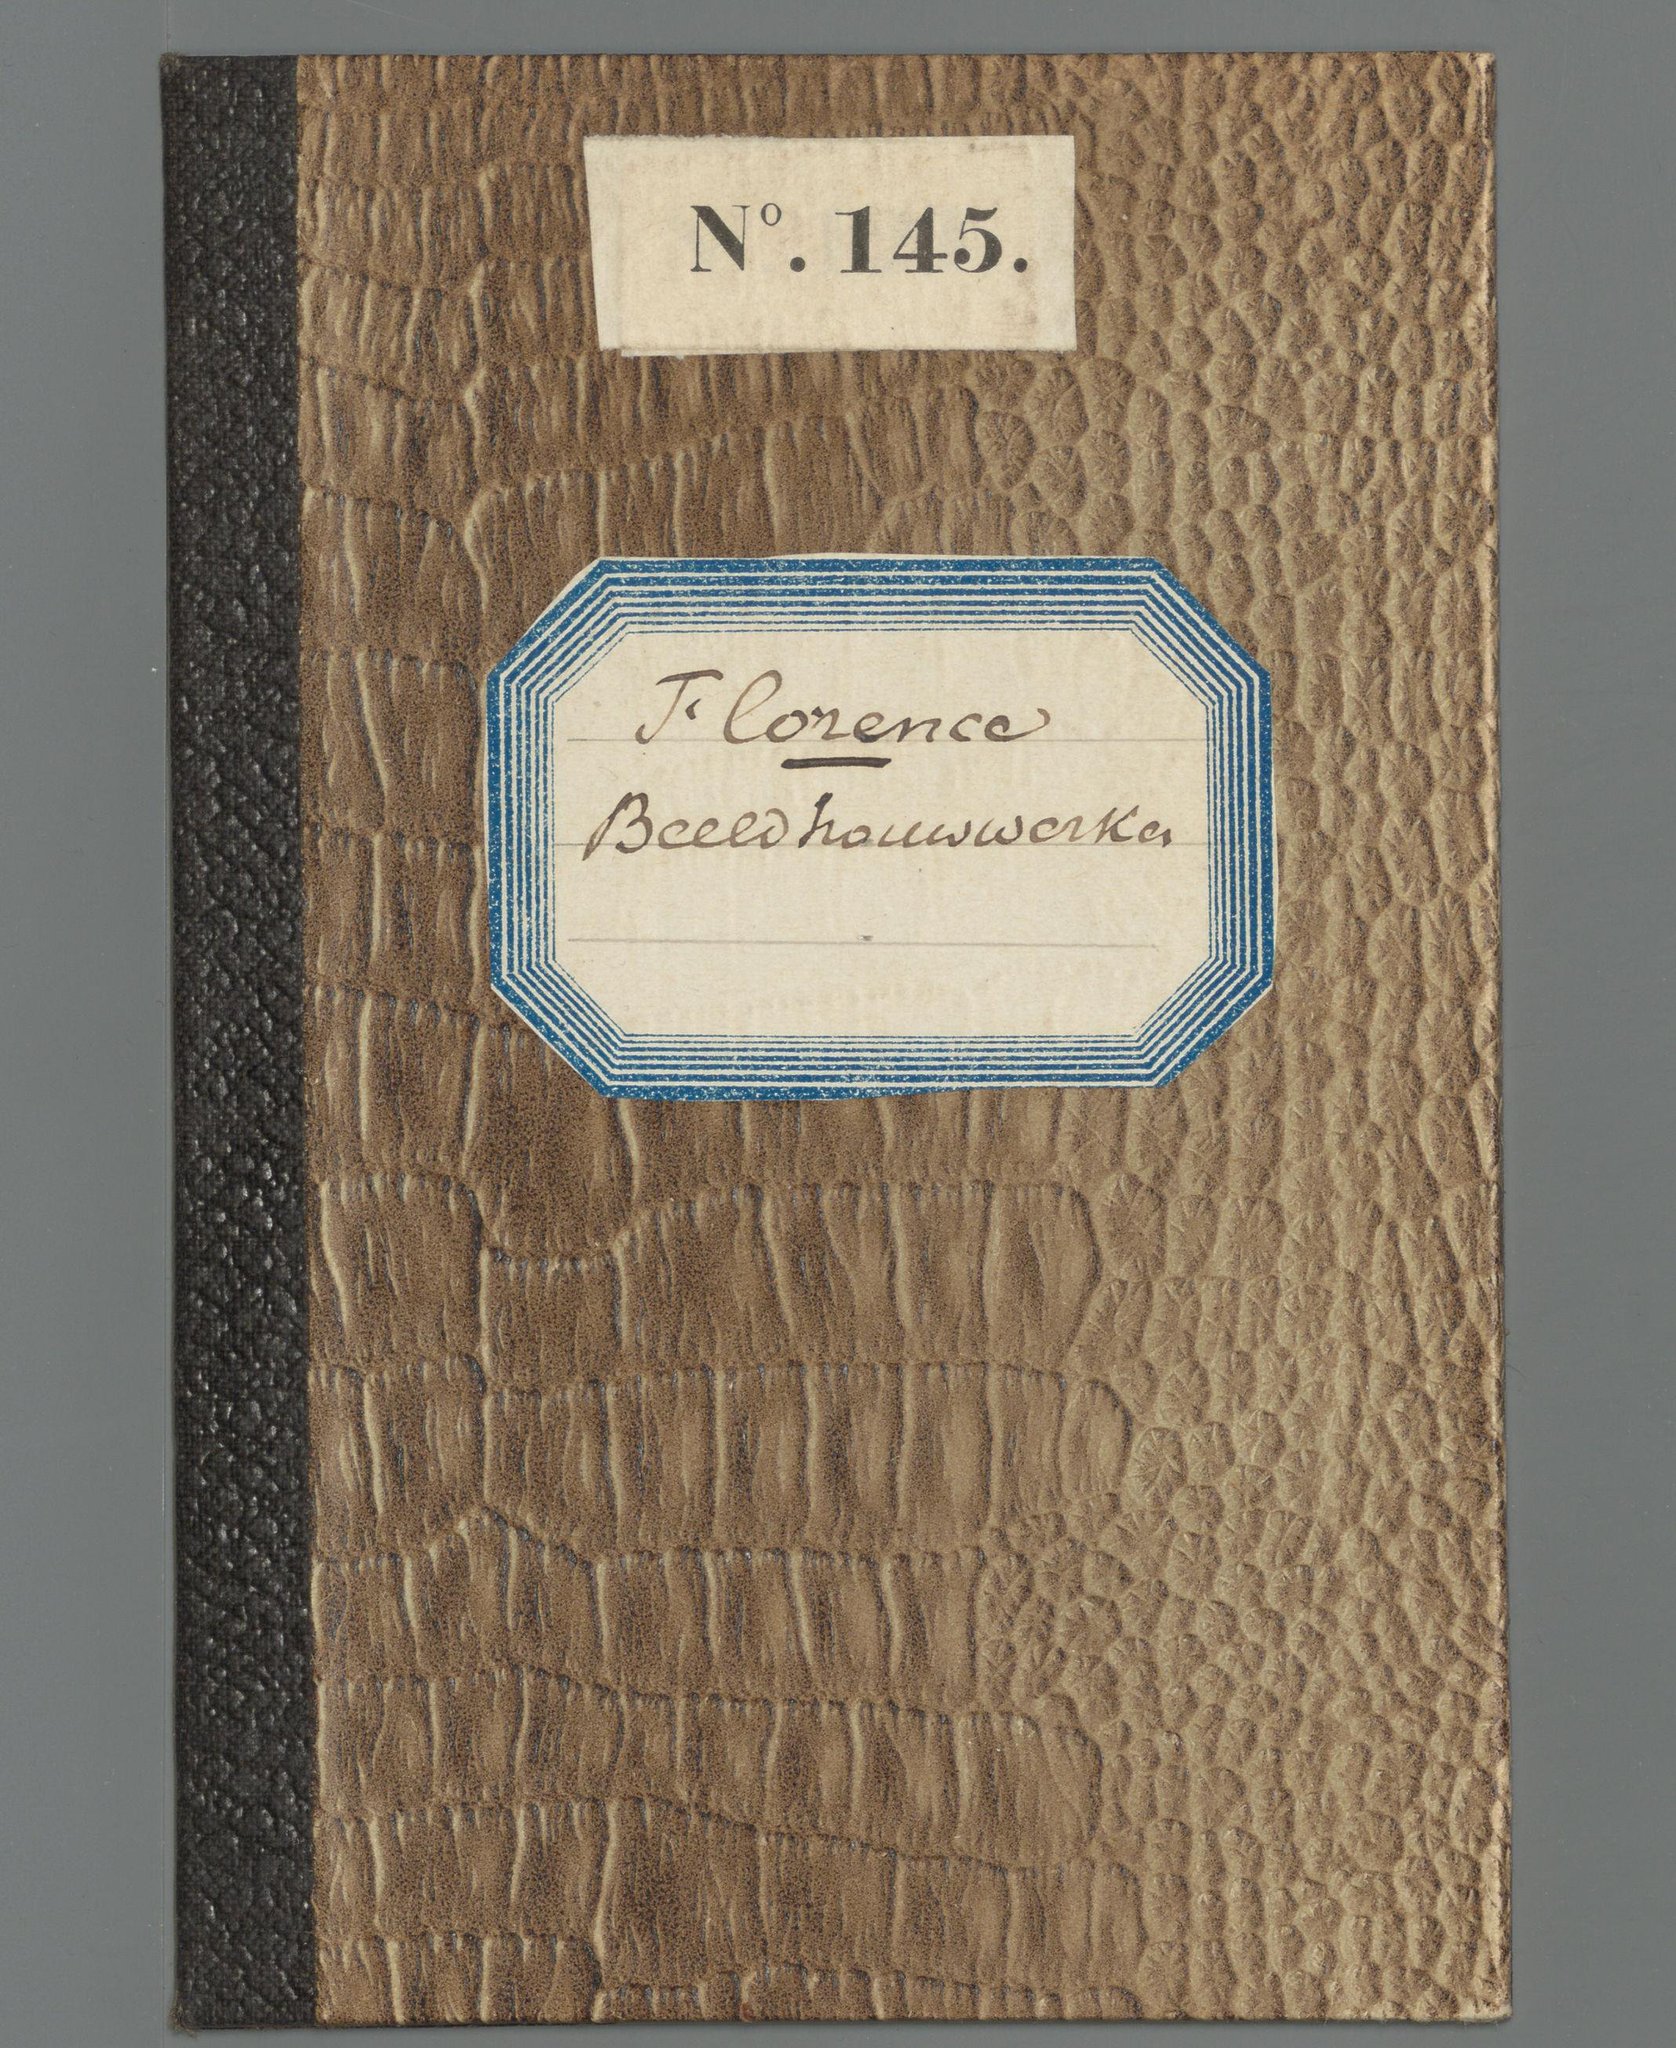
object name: wrapper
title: Florence. Beeldhouwwerken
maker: Anonymous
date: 1900-1950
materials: cardboard, ink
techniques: pen